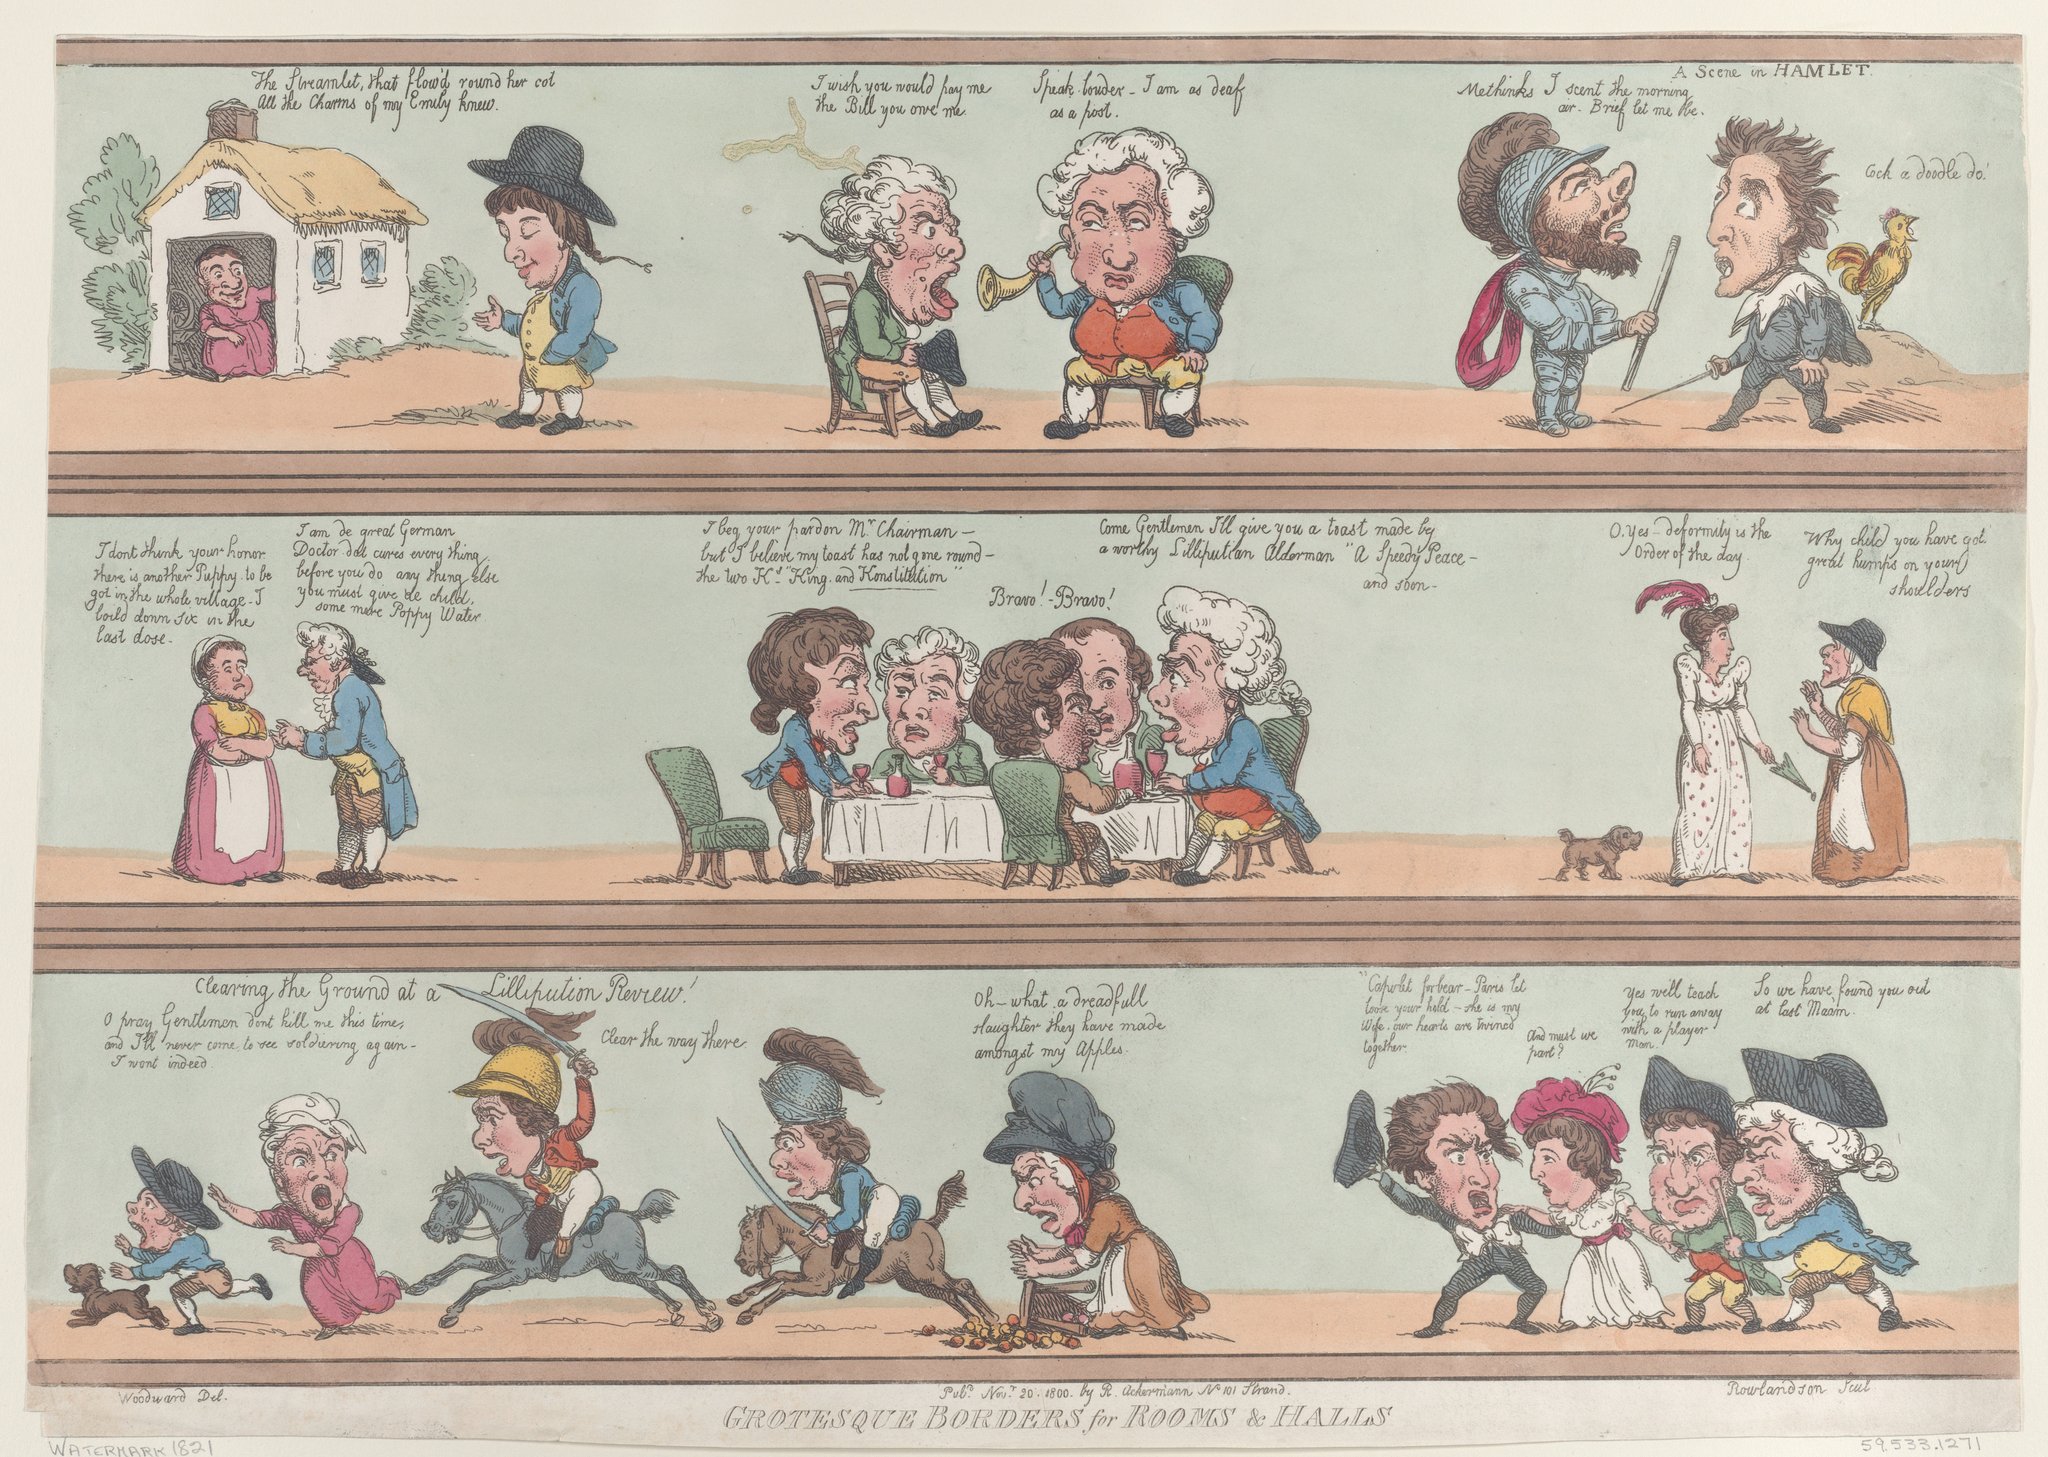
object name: print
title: Grotesque Borders for Rooms & Halls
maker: thomas rowlandson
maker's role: artist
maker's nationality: british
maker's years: 1757-1827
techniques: etching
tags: satire,men,women,horses